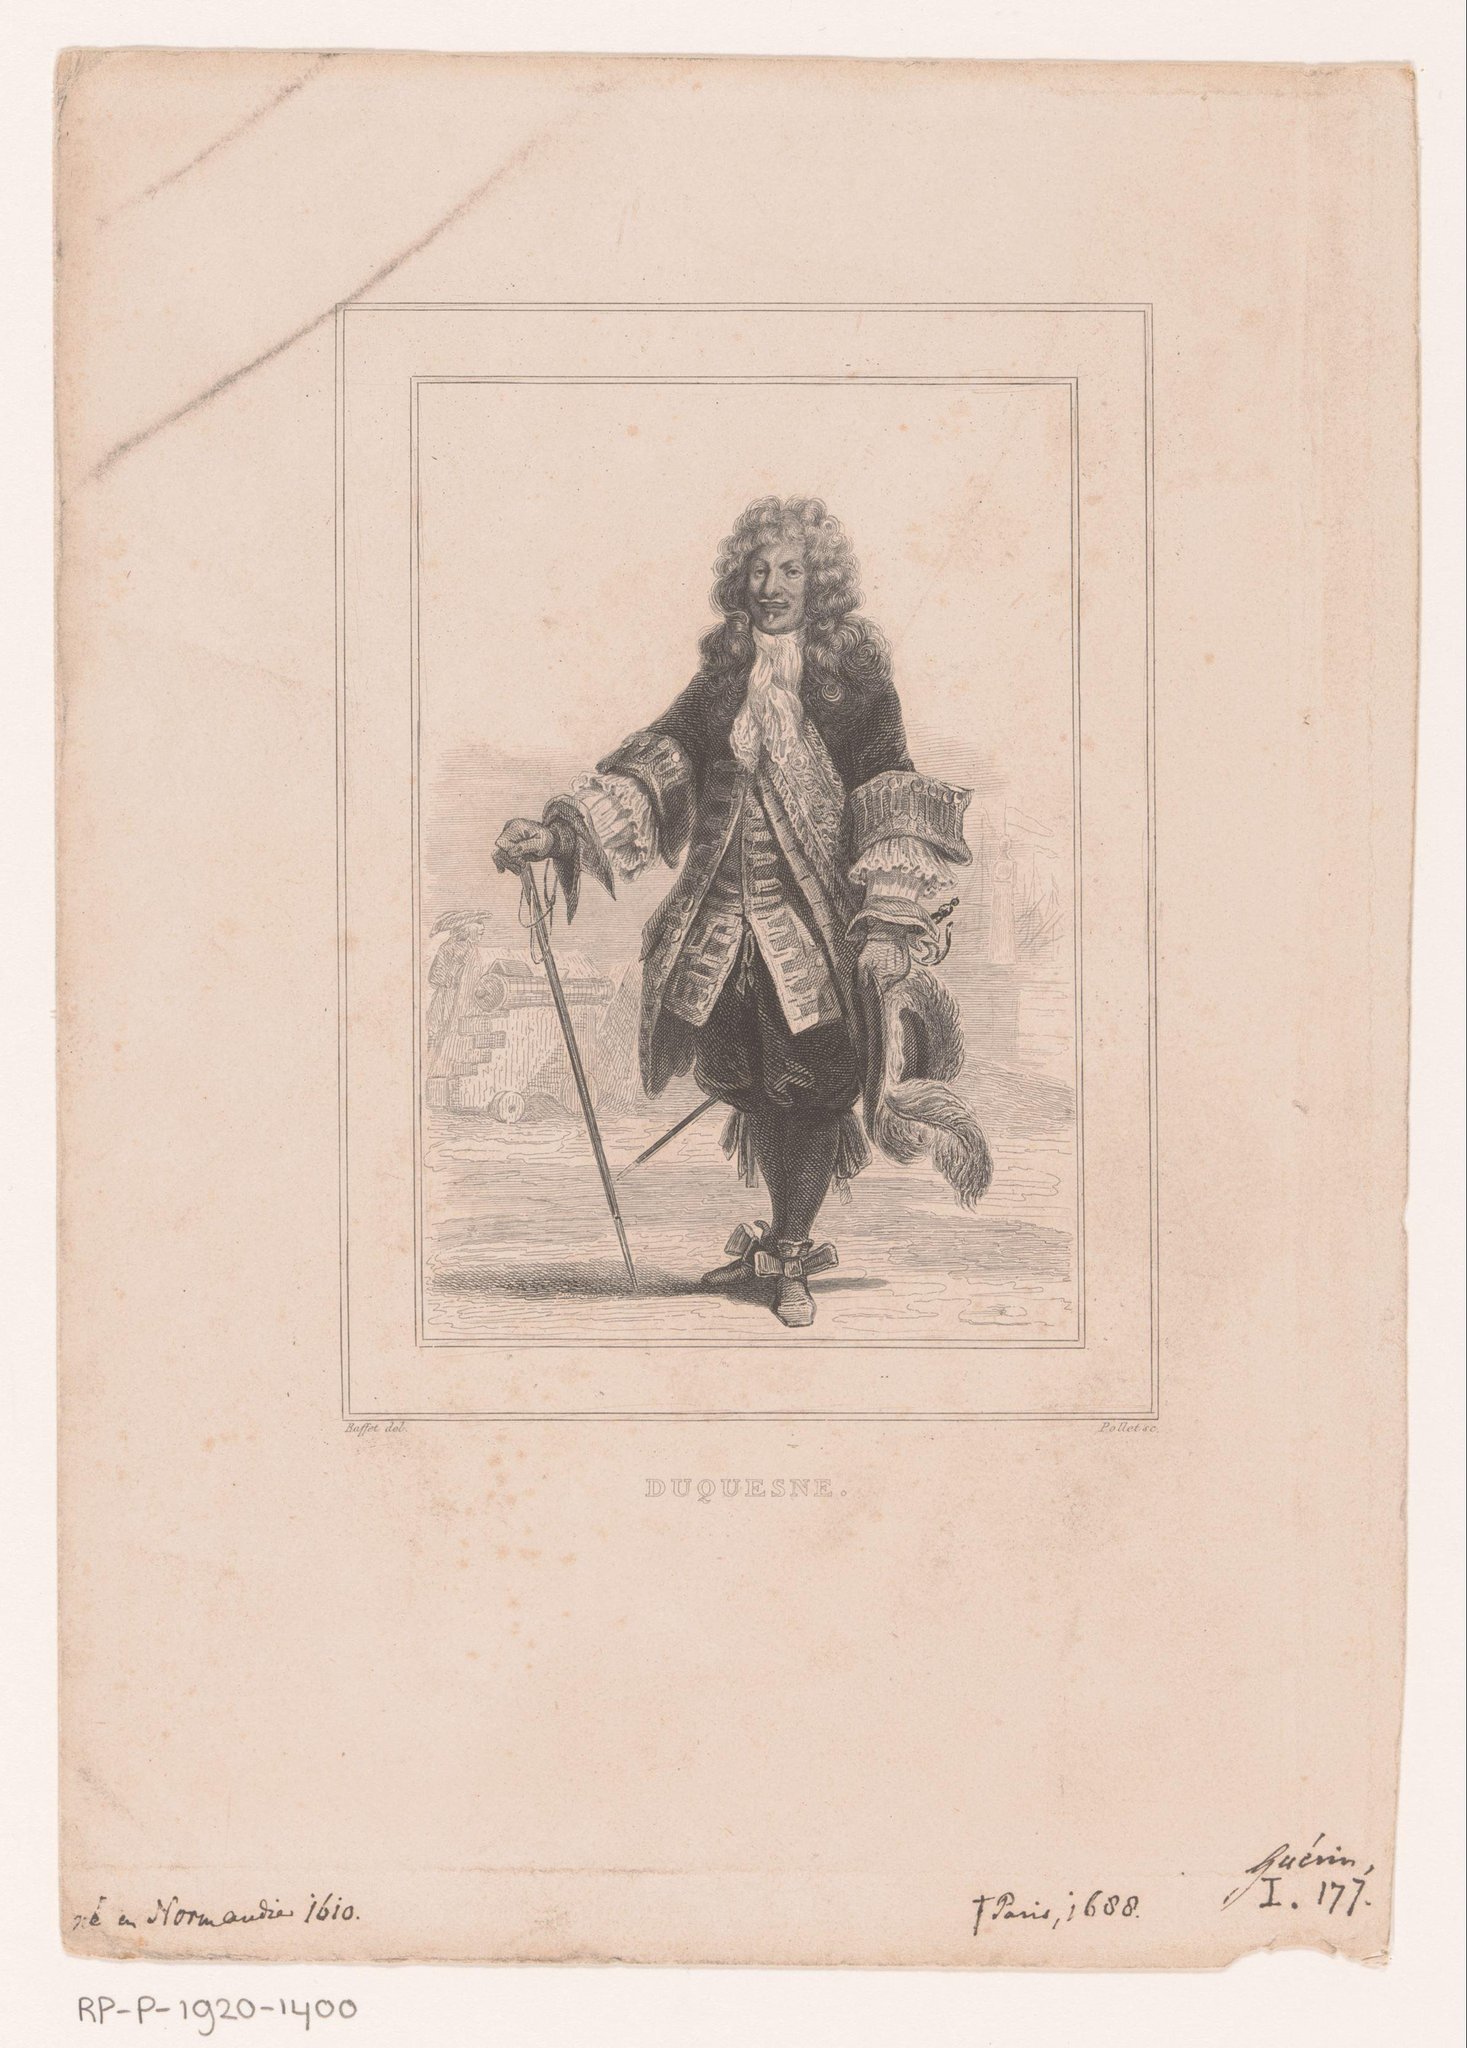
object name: book illustration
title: Portret van Abraham Duquesne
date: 1835-1837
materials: paper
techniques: etching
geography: paris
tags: paris, historical persons, ranks in the navy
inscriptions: collector's mark: Lugt 2228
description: Prent uit: Sue, Eugène. Histoire de la marine française. Parijs: Félix Bonnaire, 1835-1837, 5 delen.